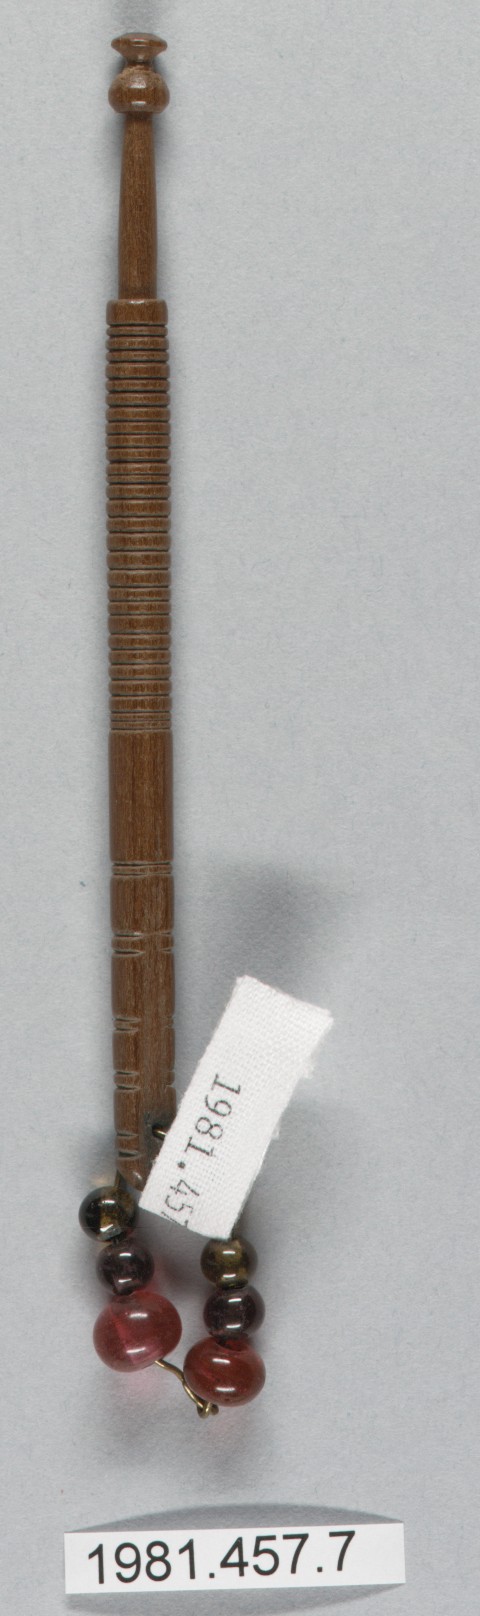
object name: bobbin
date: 1840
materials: wood